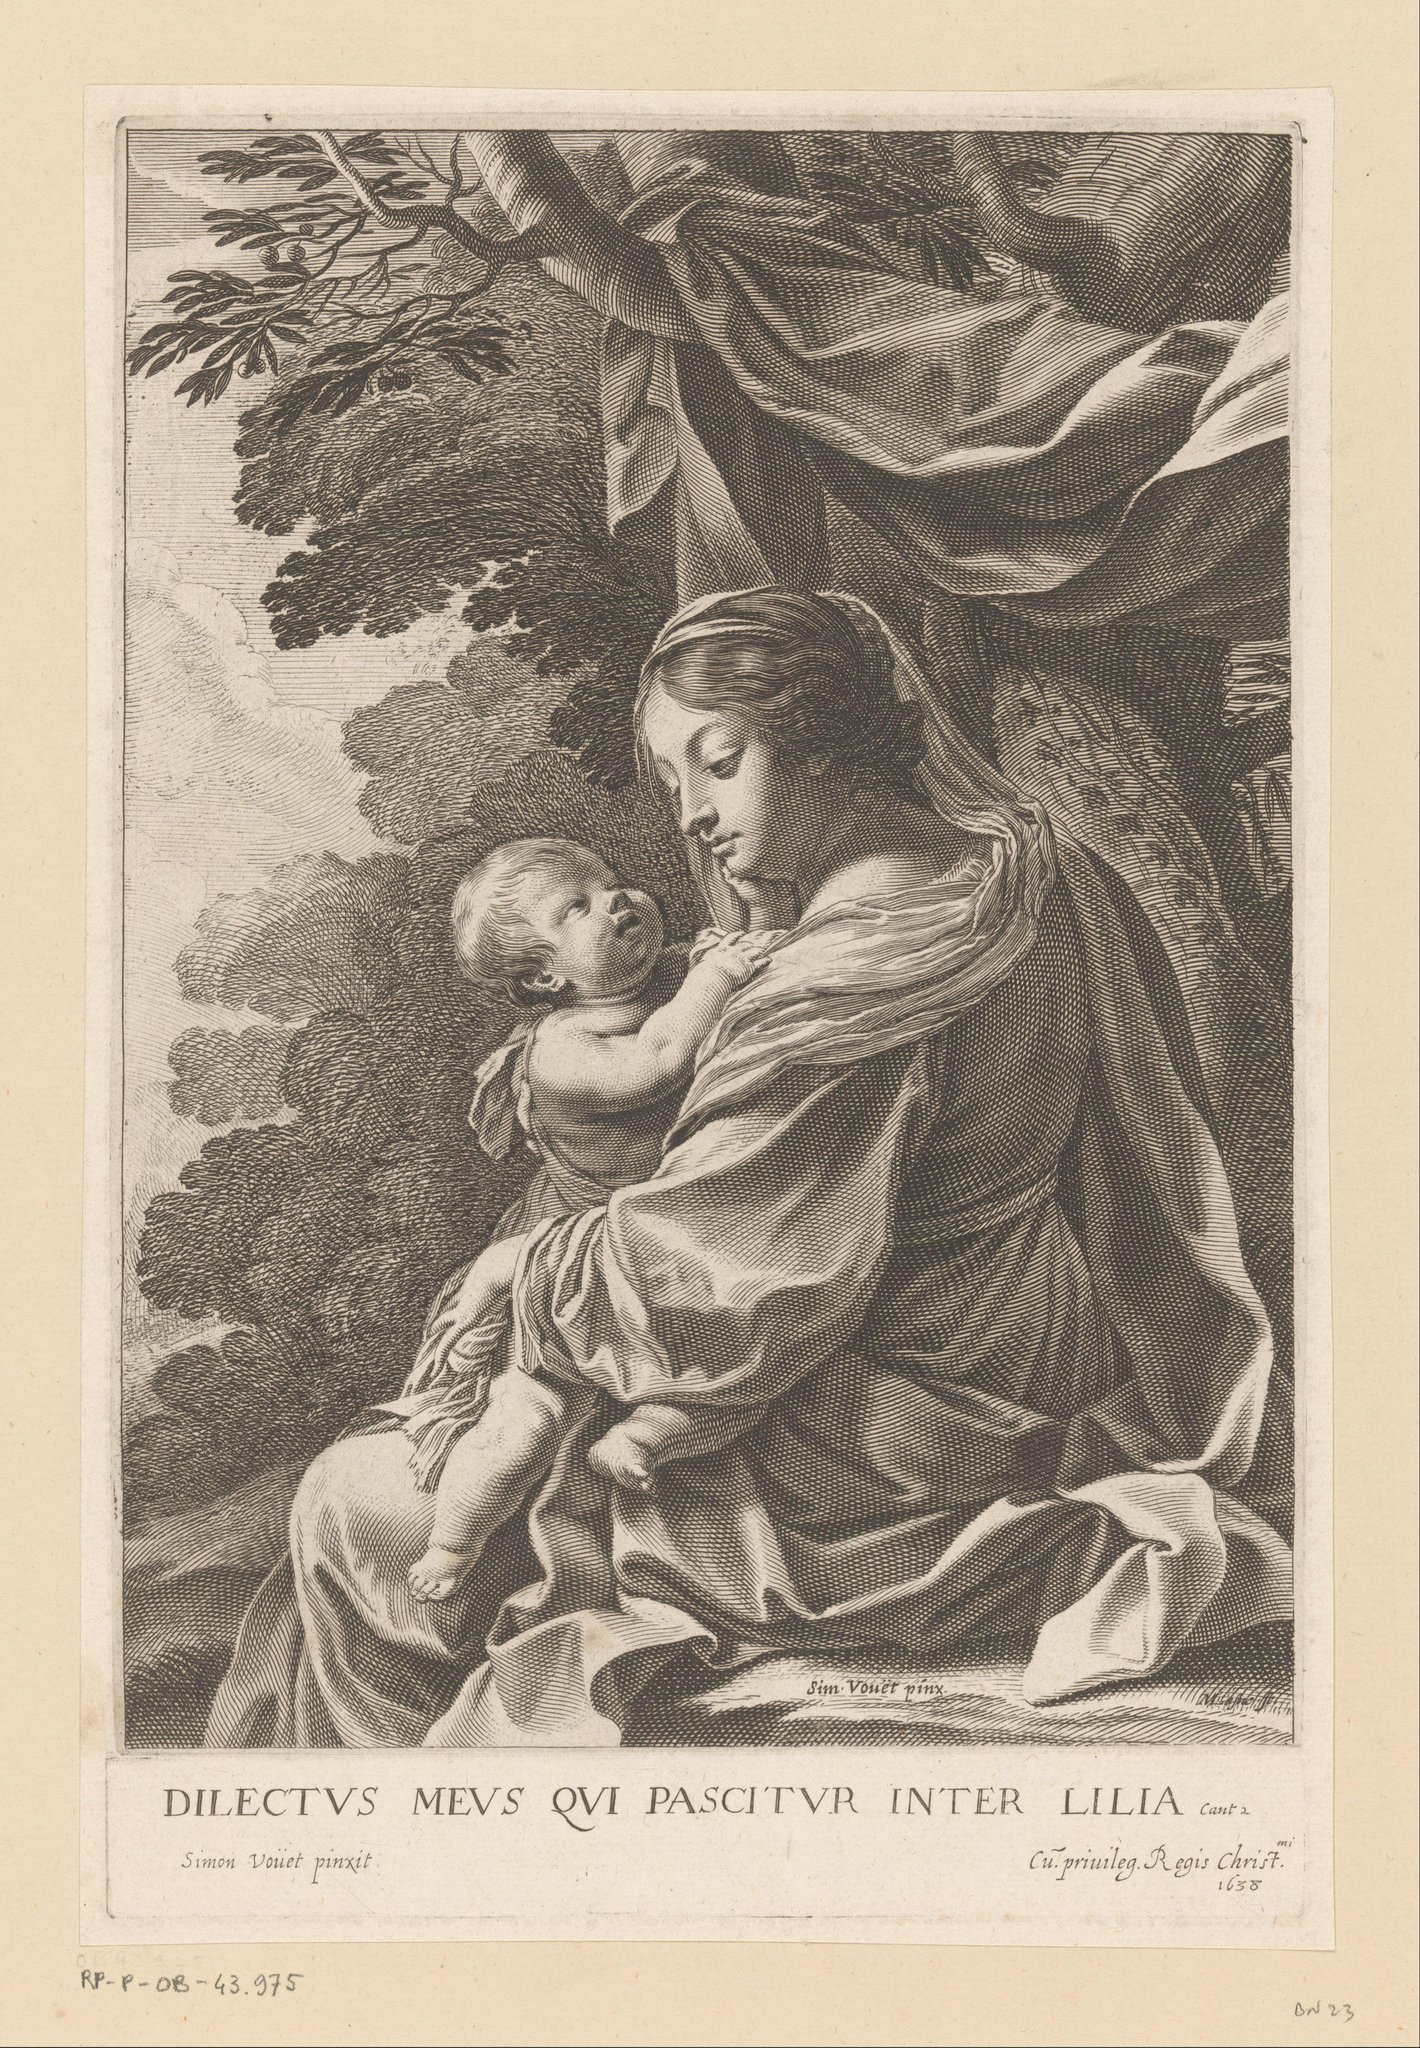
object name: print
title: Maria met kind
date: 1638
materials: paper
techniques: engraving, etching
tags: madonna: mary sitting or enthroned, the christ-child in her lap (or in front of her bosom) (mary sometimes represented half-length)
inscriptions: collector's mark: Lugt 240